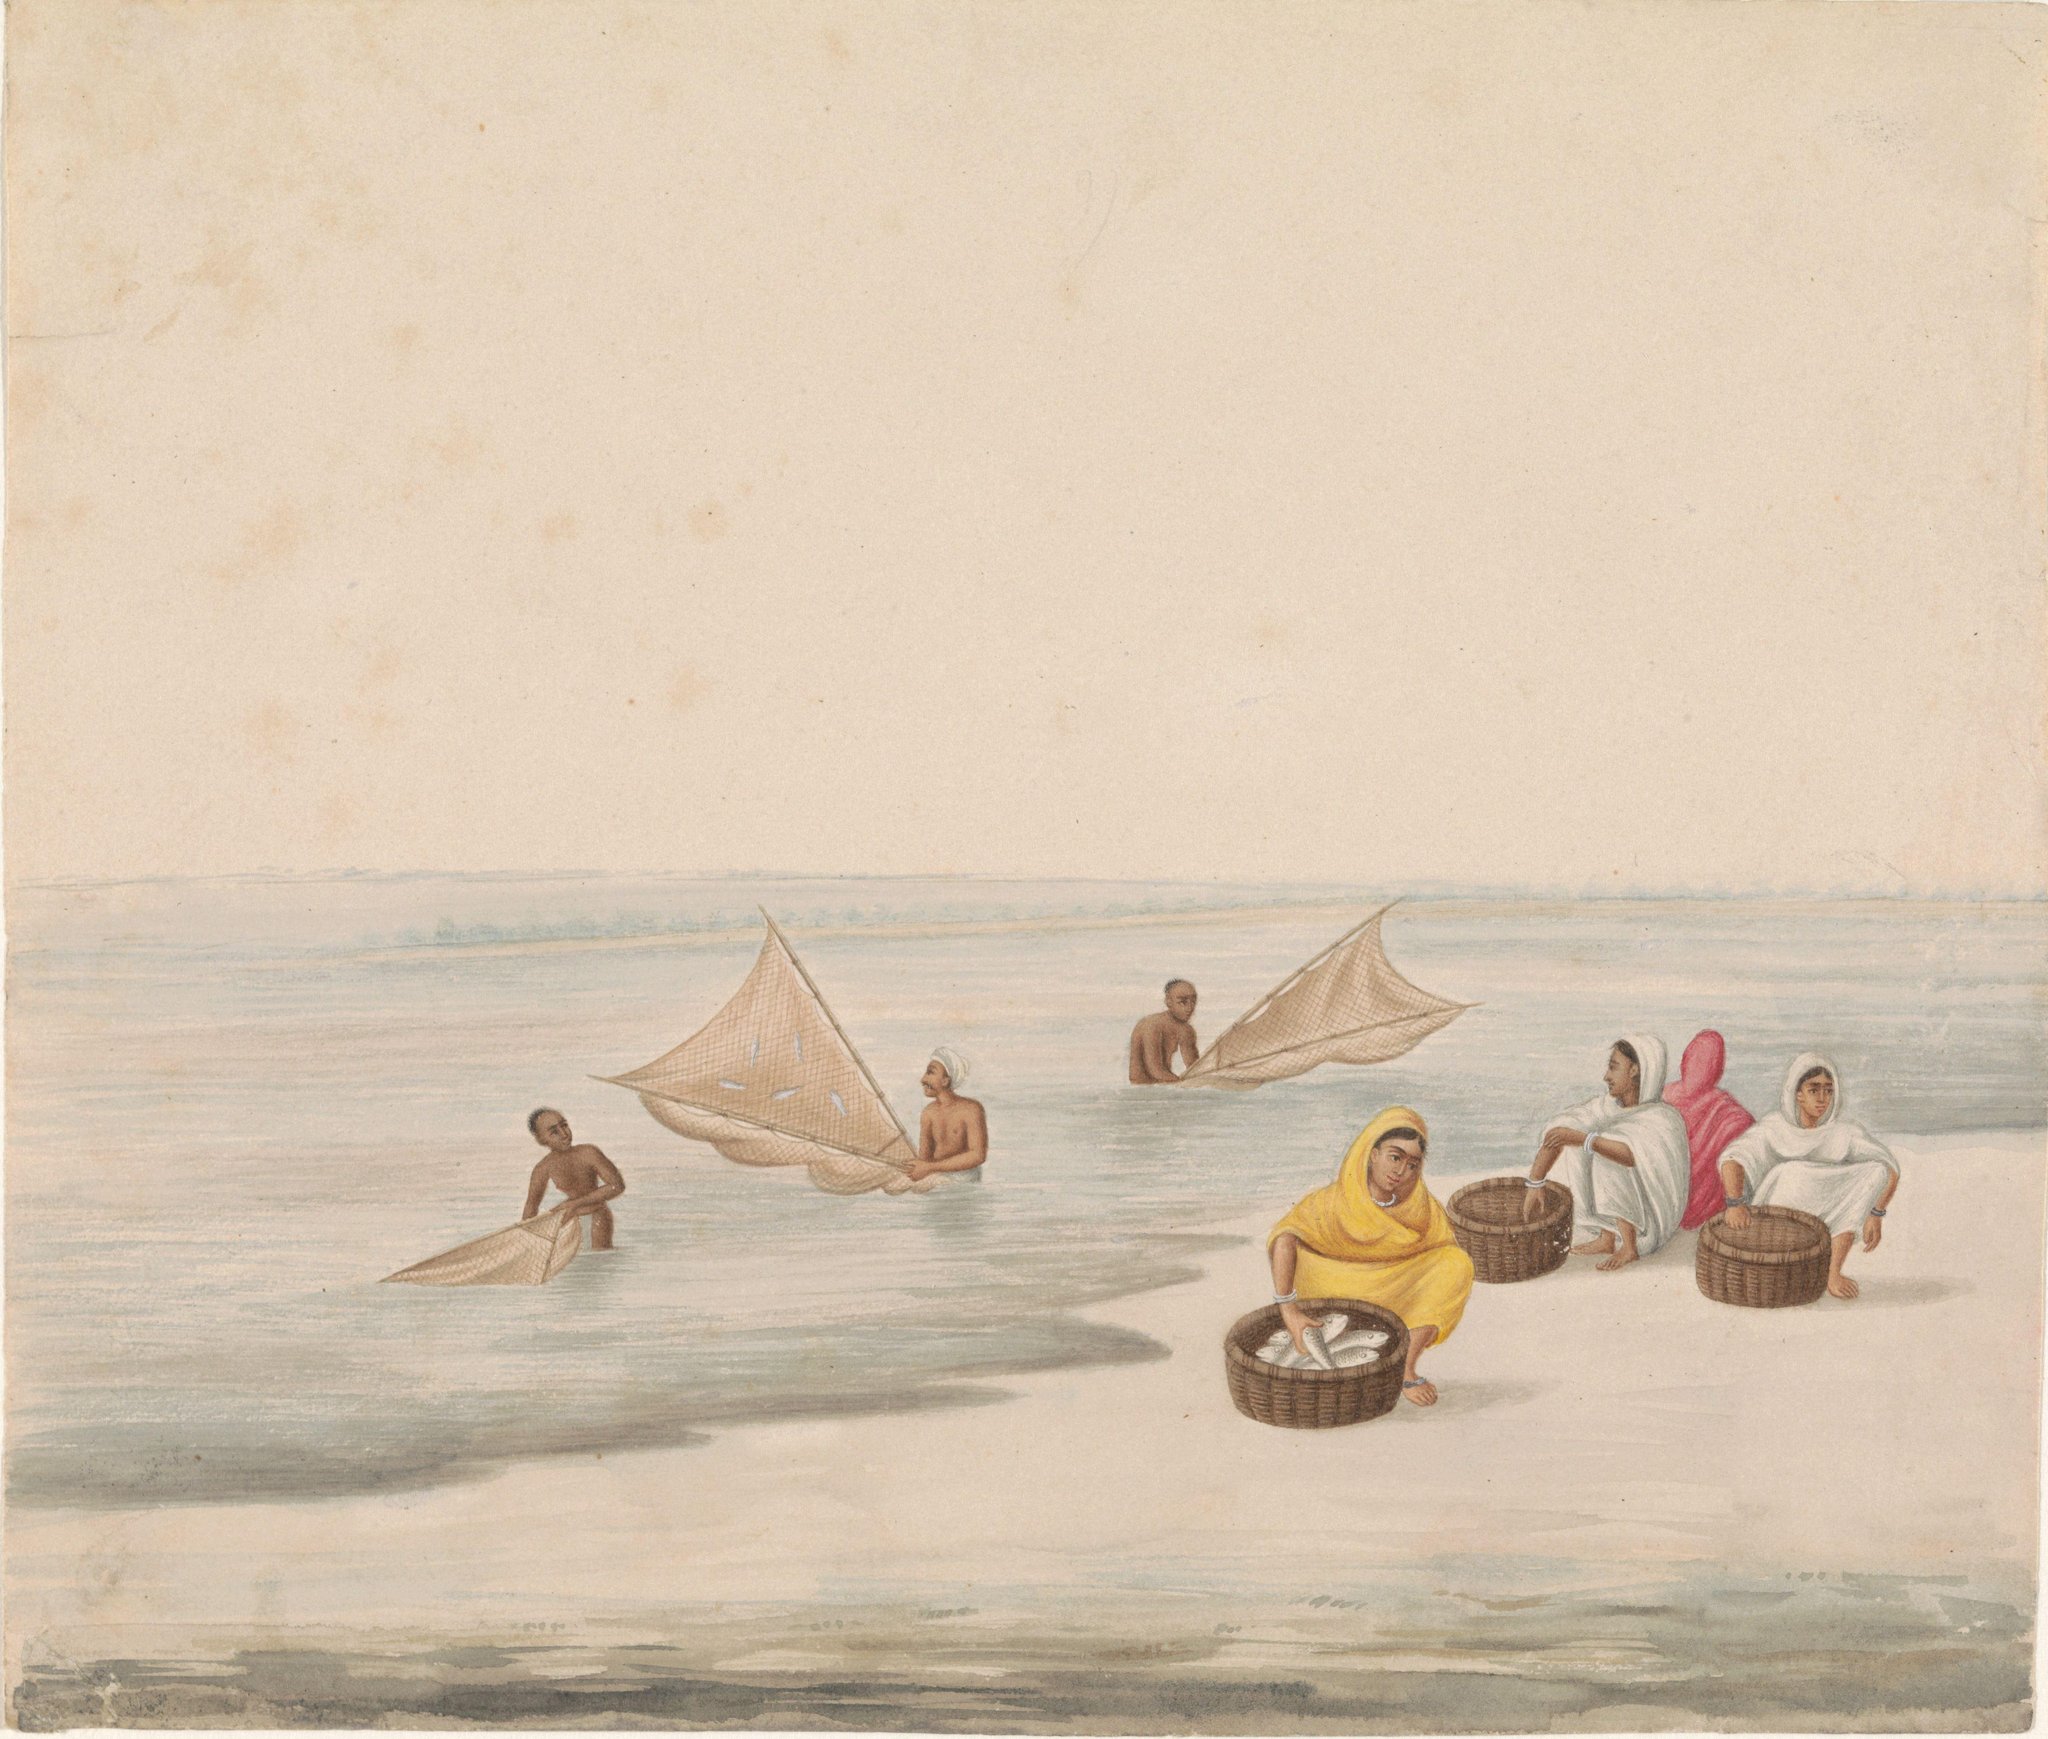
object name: indian miniature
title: Vissers en vrouwen langs het water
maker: Anonymous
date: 1870-1890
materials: paper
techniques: brush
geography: india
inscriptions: inscription: ‘.’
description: Een lichtgekleurde voorstelling van een drietal vissers met hun netten in het water en vier vrouwen op het droge met vismanden.